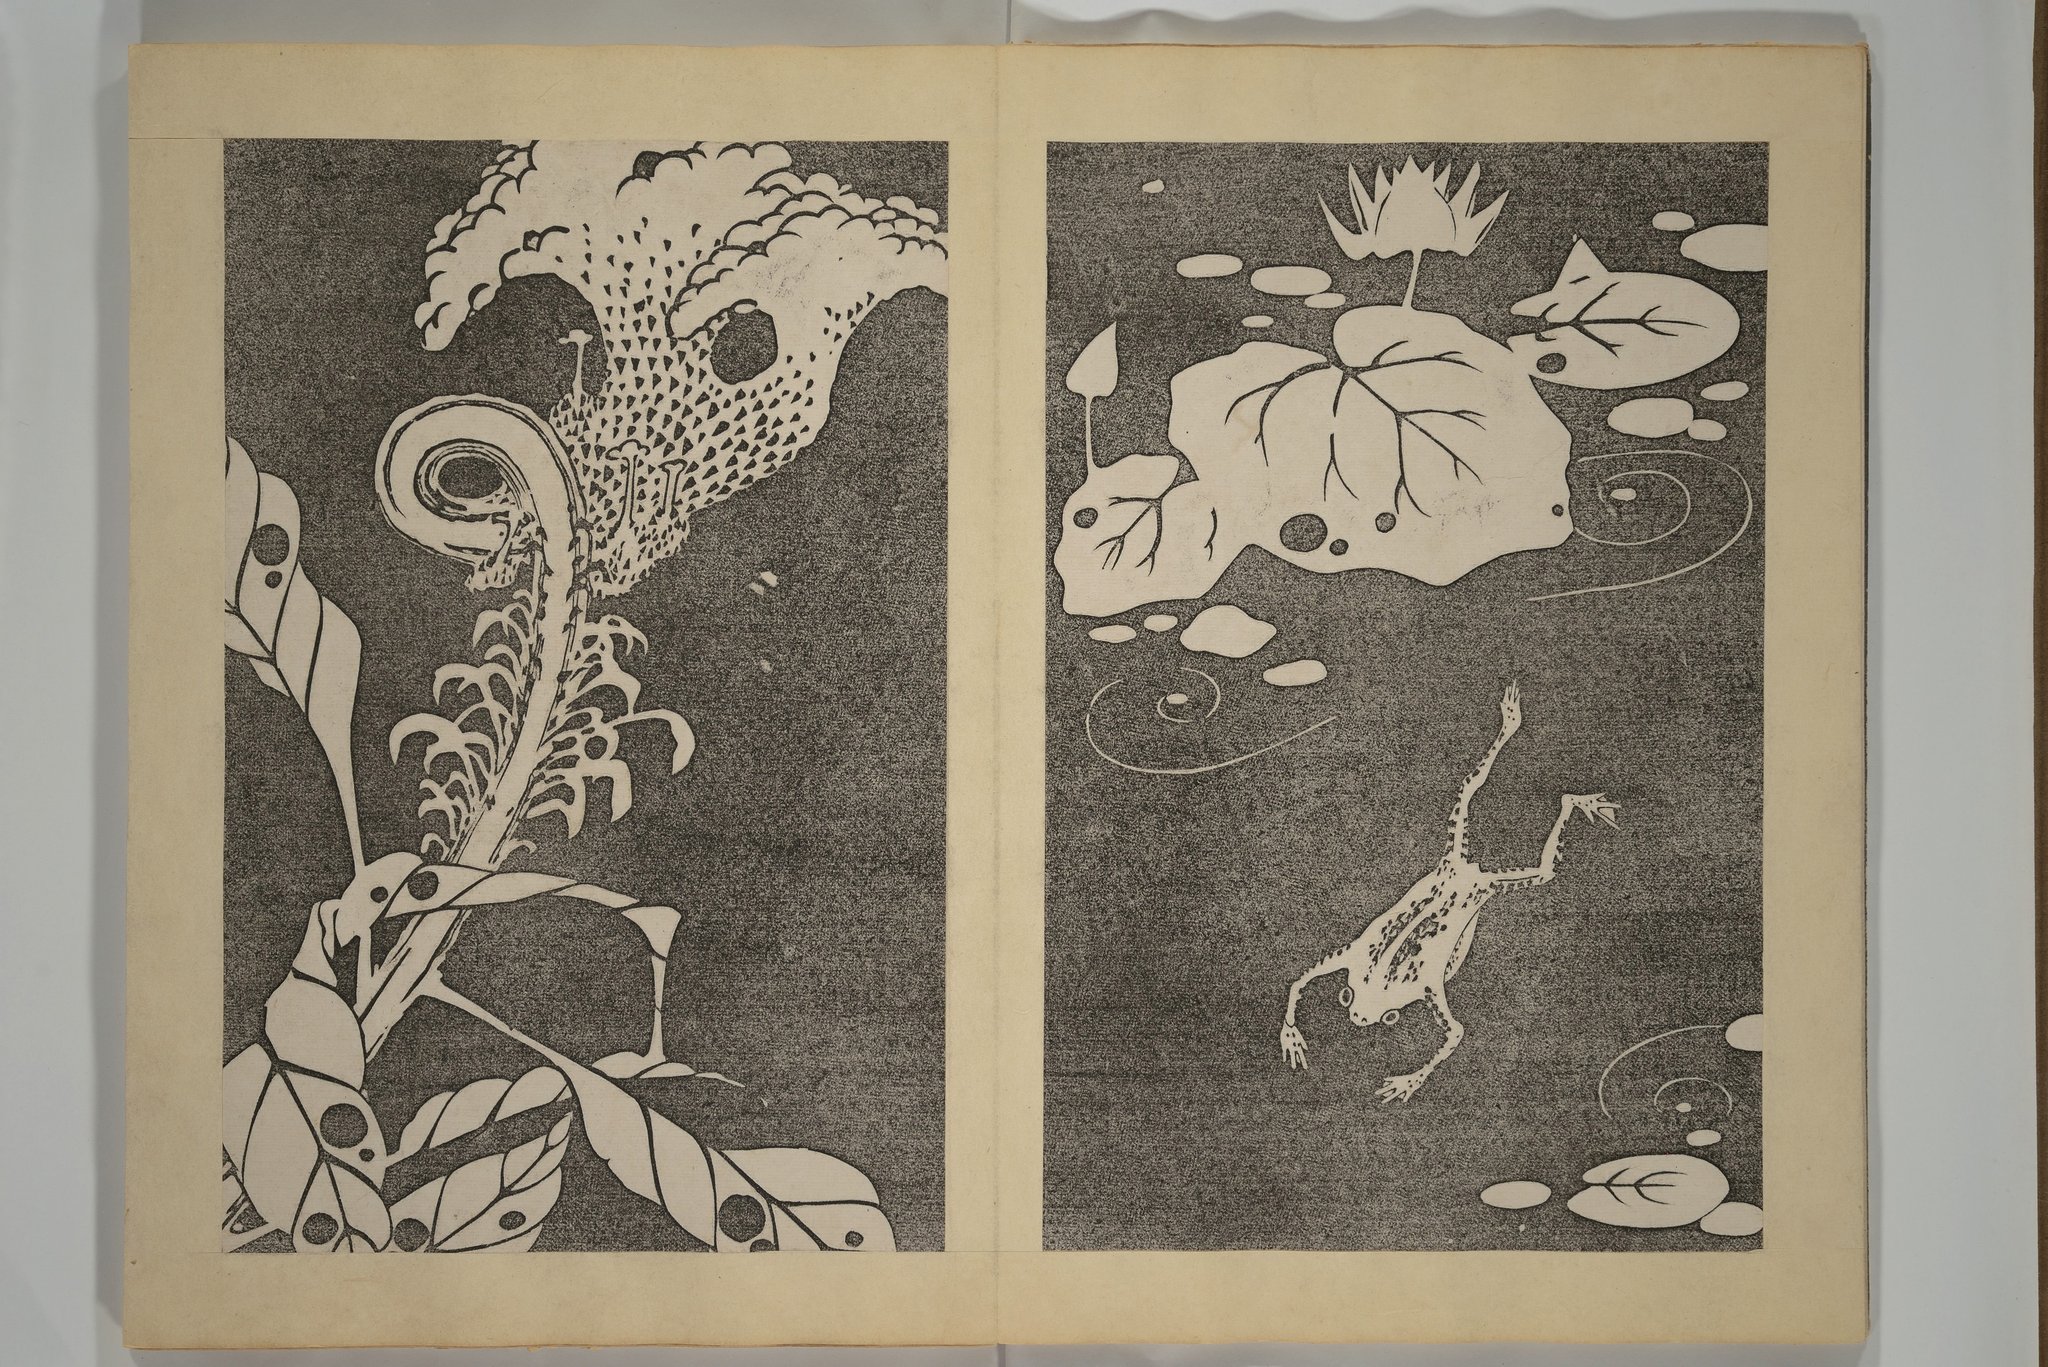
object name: illustrated book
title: Jakuchū Picture Album (Jakuchū gajō} 若冲画帖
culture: japanese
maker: itō jakuchū 伊藤若冲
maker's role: artist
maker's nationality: japanese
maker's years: 1716-1800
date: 1900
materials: ink, paper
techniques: woodblock print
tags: frogs,flowers,leaves